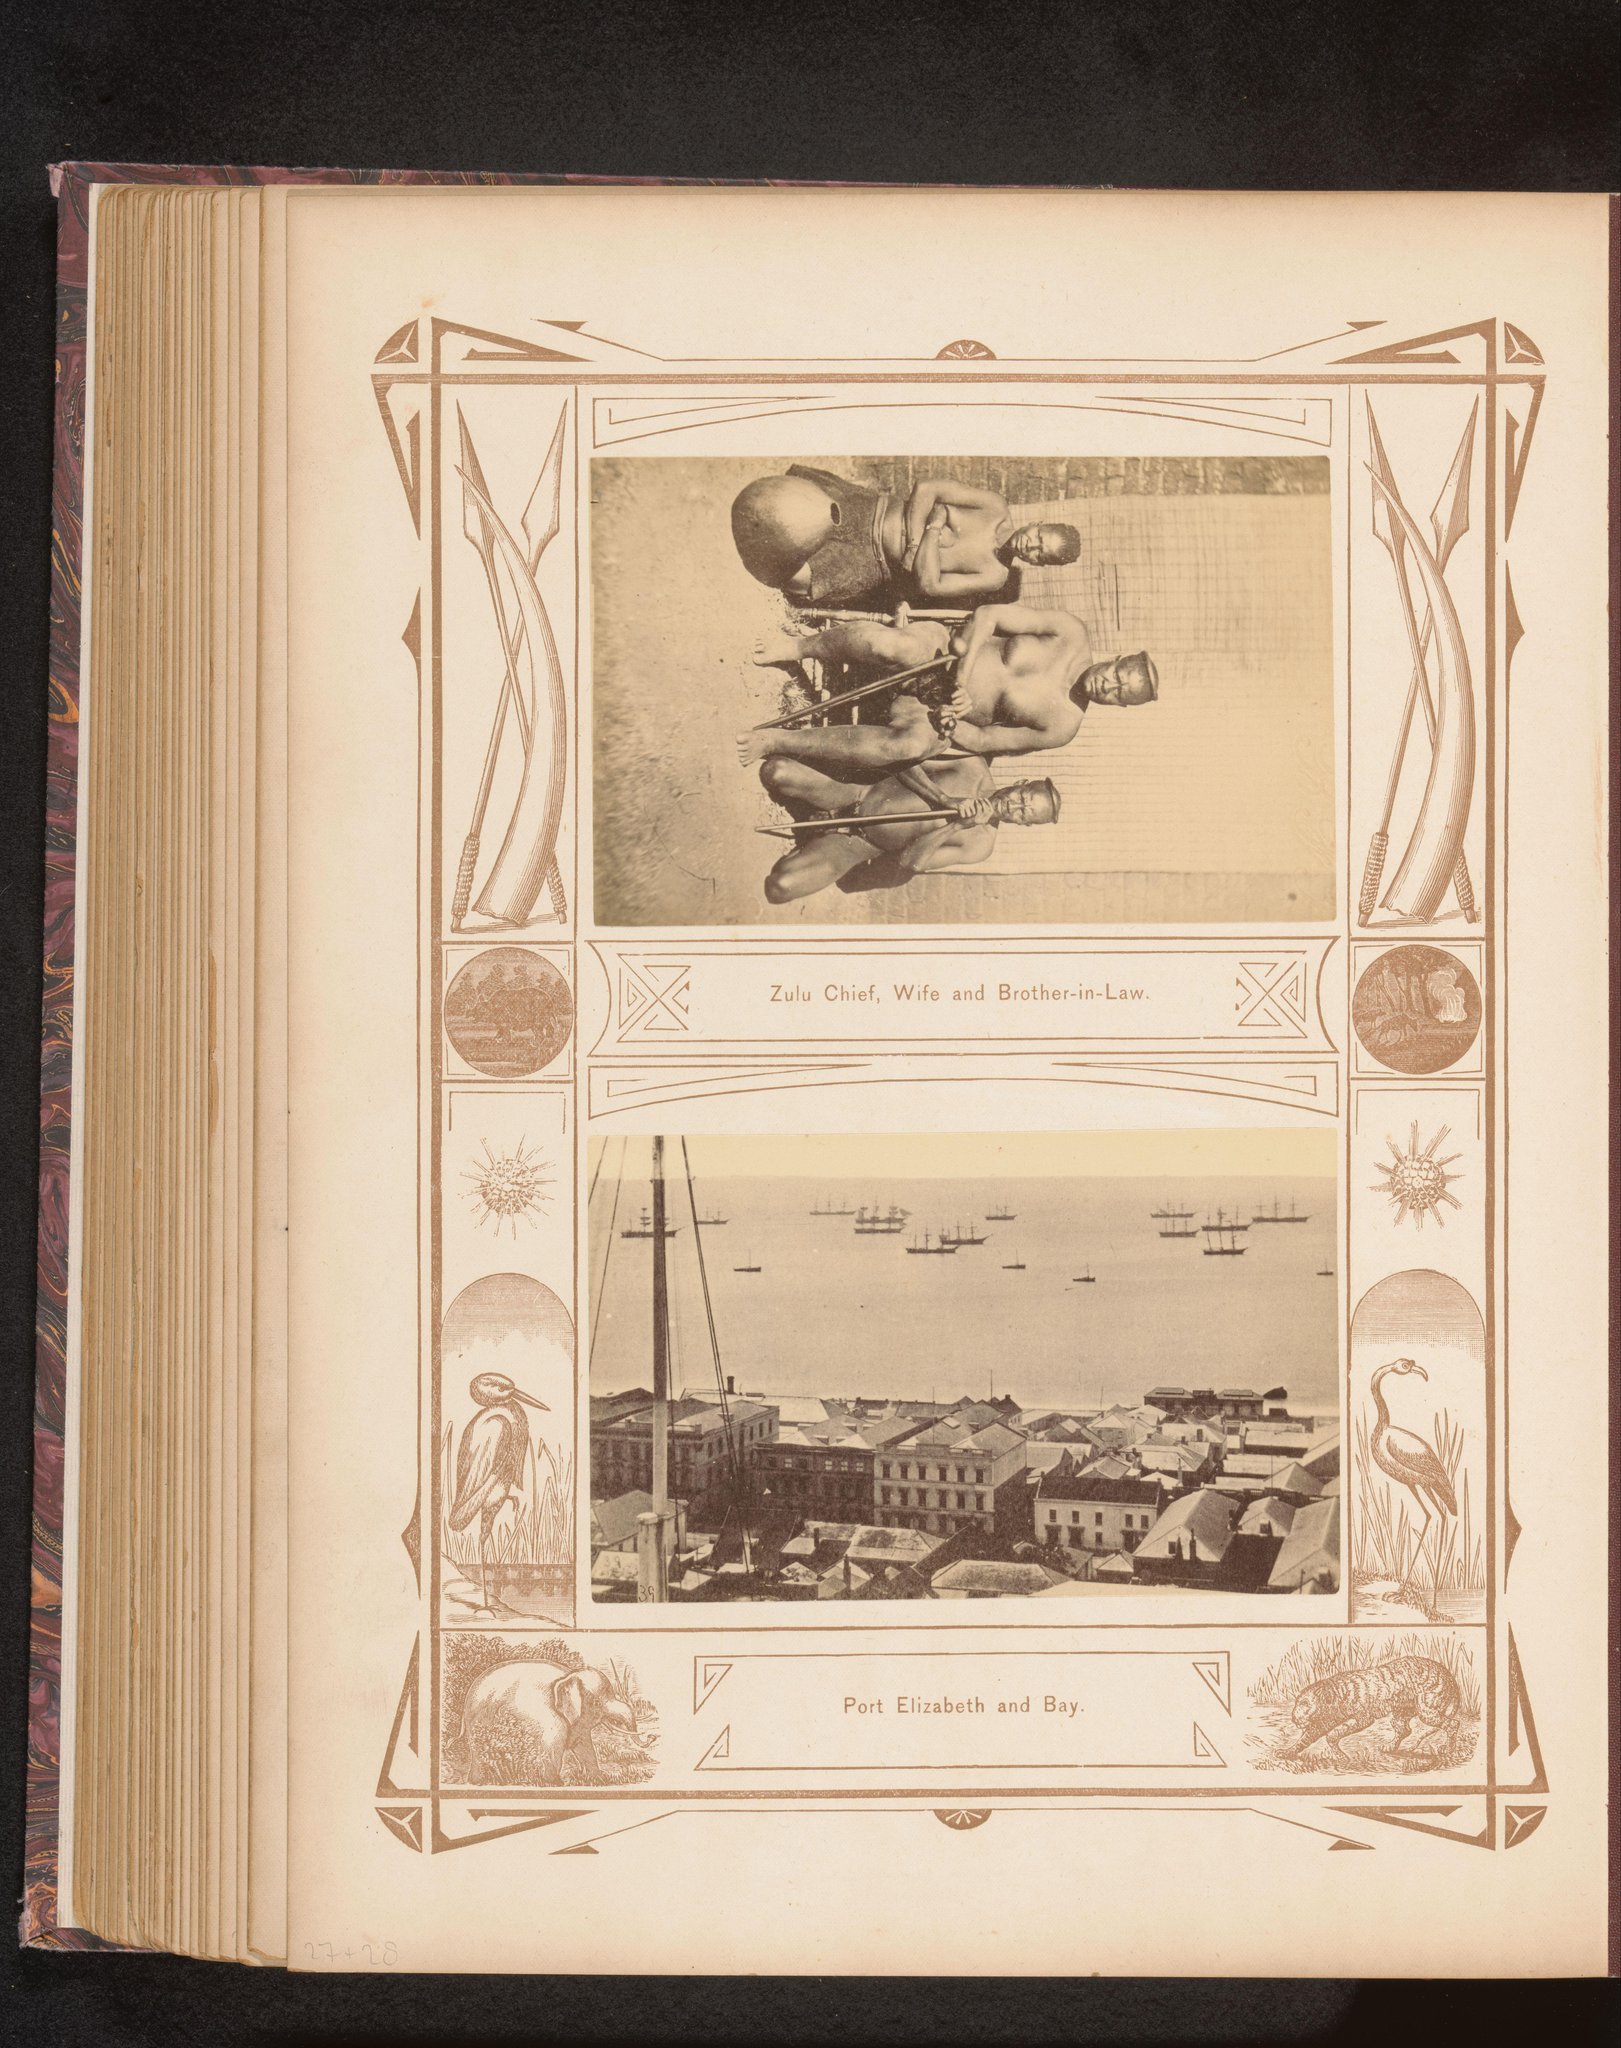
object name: page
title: Gezicht op Port Elizabeth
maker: Anonymous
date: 1877-1882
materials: photographic support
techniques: albumen print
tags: city-view in general; 'veduta', sea (seascape)